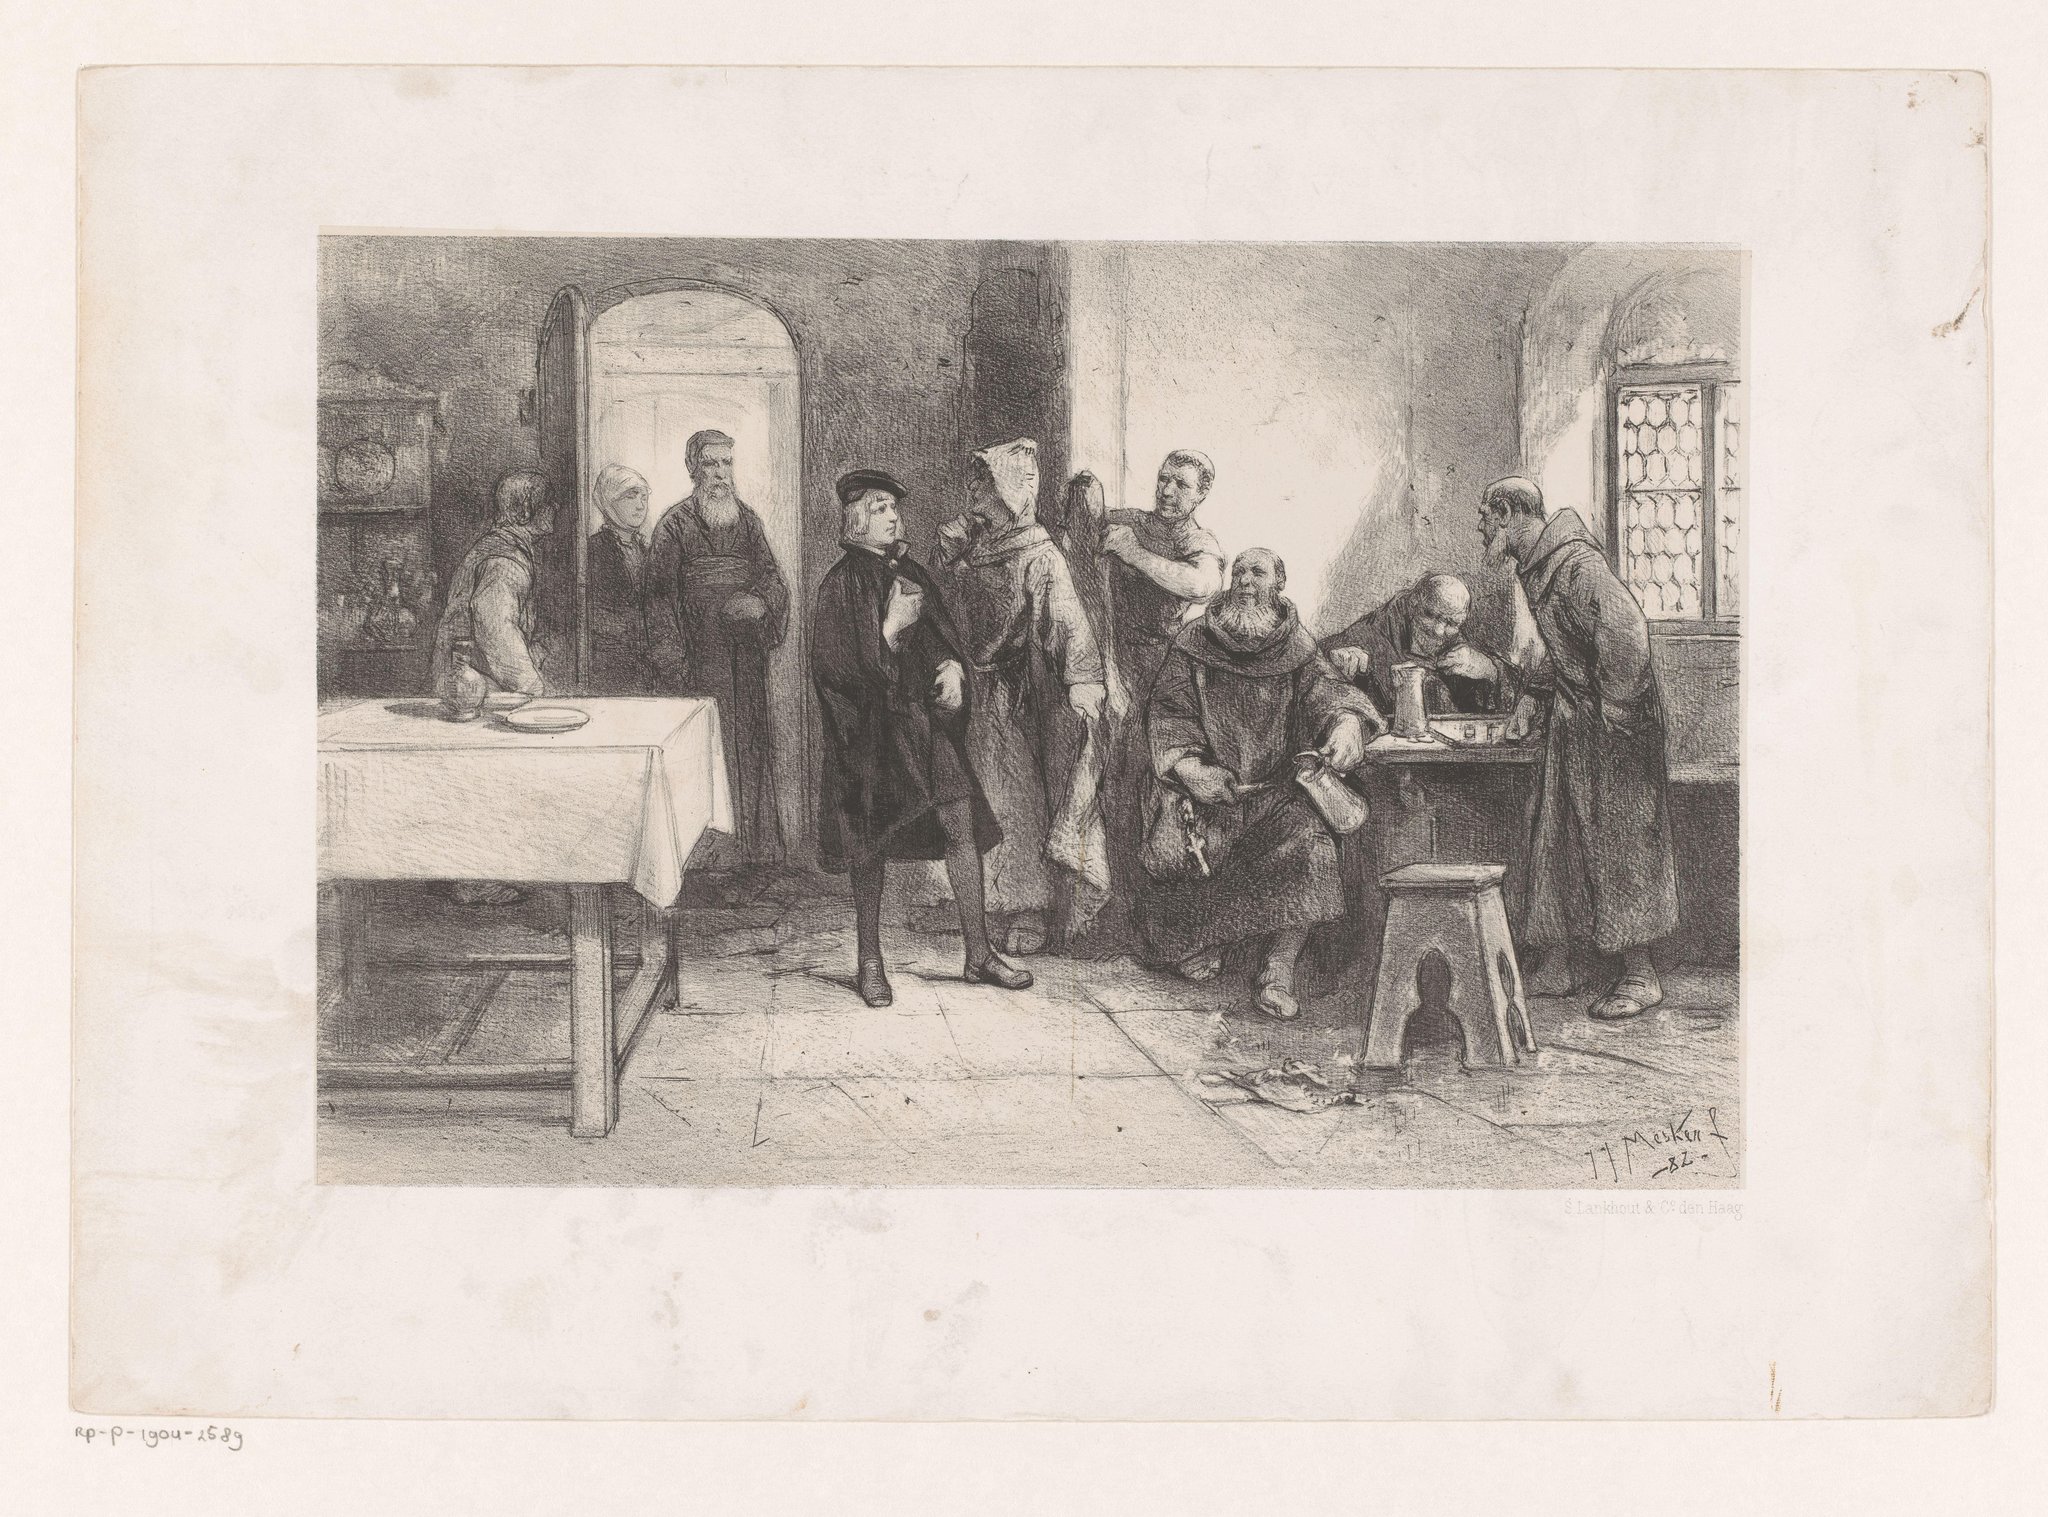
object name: print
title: Paul van Mansveld wordt bespot door Kapucijner monniken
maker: jan mesker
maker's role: print maker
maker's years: 1843-1890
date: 1882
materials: paper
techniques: lithograph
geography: the hague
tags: functionaries and dignitaries (with name) ~ episcopal protestant churches, monk(s), friar(s), dice-games, hotel, hostelry, inn, specific works of literature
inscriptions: collector's mark: Lugt 2228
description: Begin van de roman Het Huis Lauernesse door A. L.G. Bosboom-Toussaint. Afgebeeld is de protestante Duitser Paul van Mansveld, die in Nederland de hervorming komt prediken. Hij wordt bespot door drinkende monniken die in een herberg aan het dobbelen zijn. In de deuropening staat de vicaris van Utrecht. Hij neemt Van Mansveld mee naar het Huis Lauernesse en jonkvrouw Ottelijne.